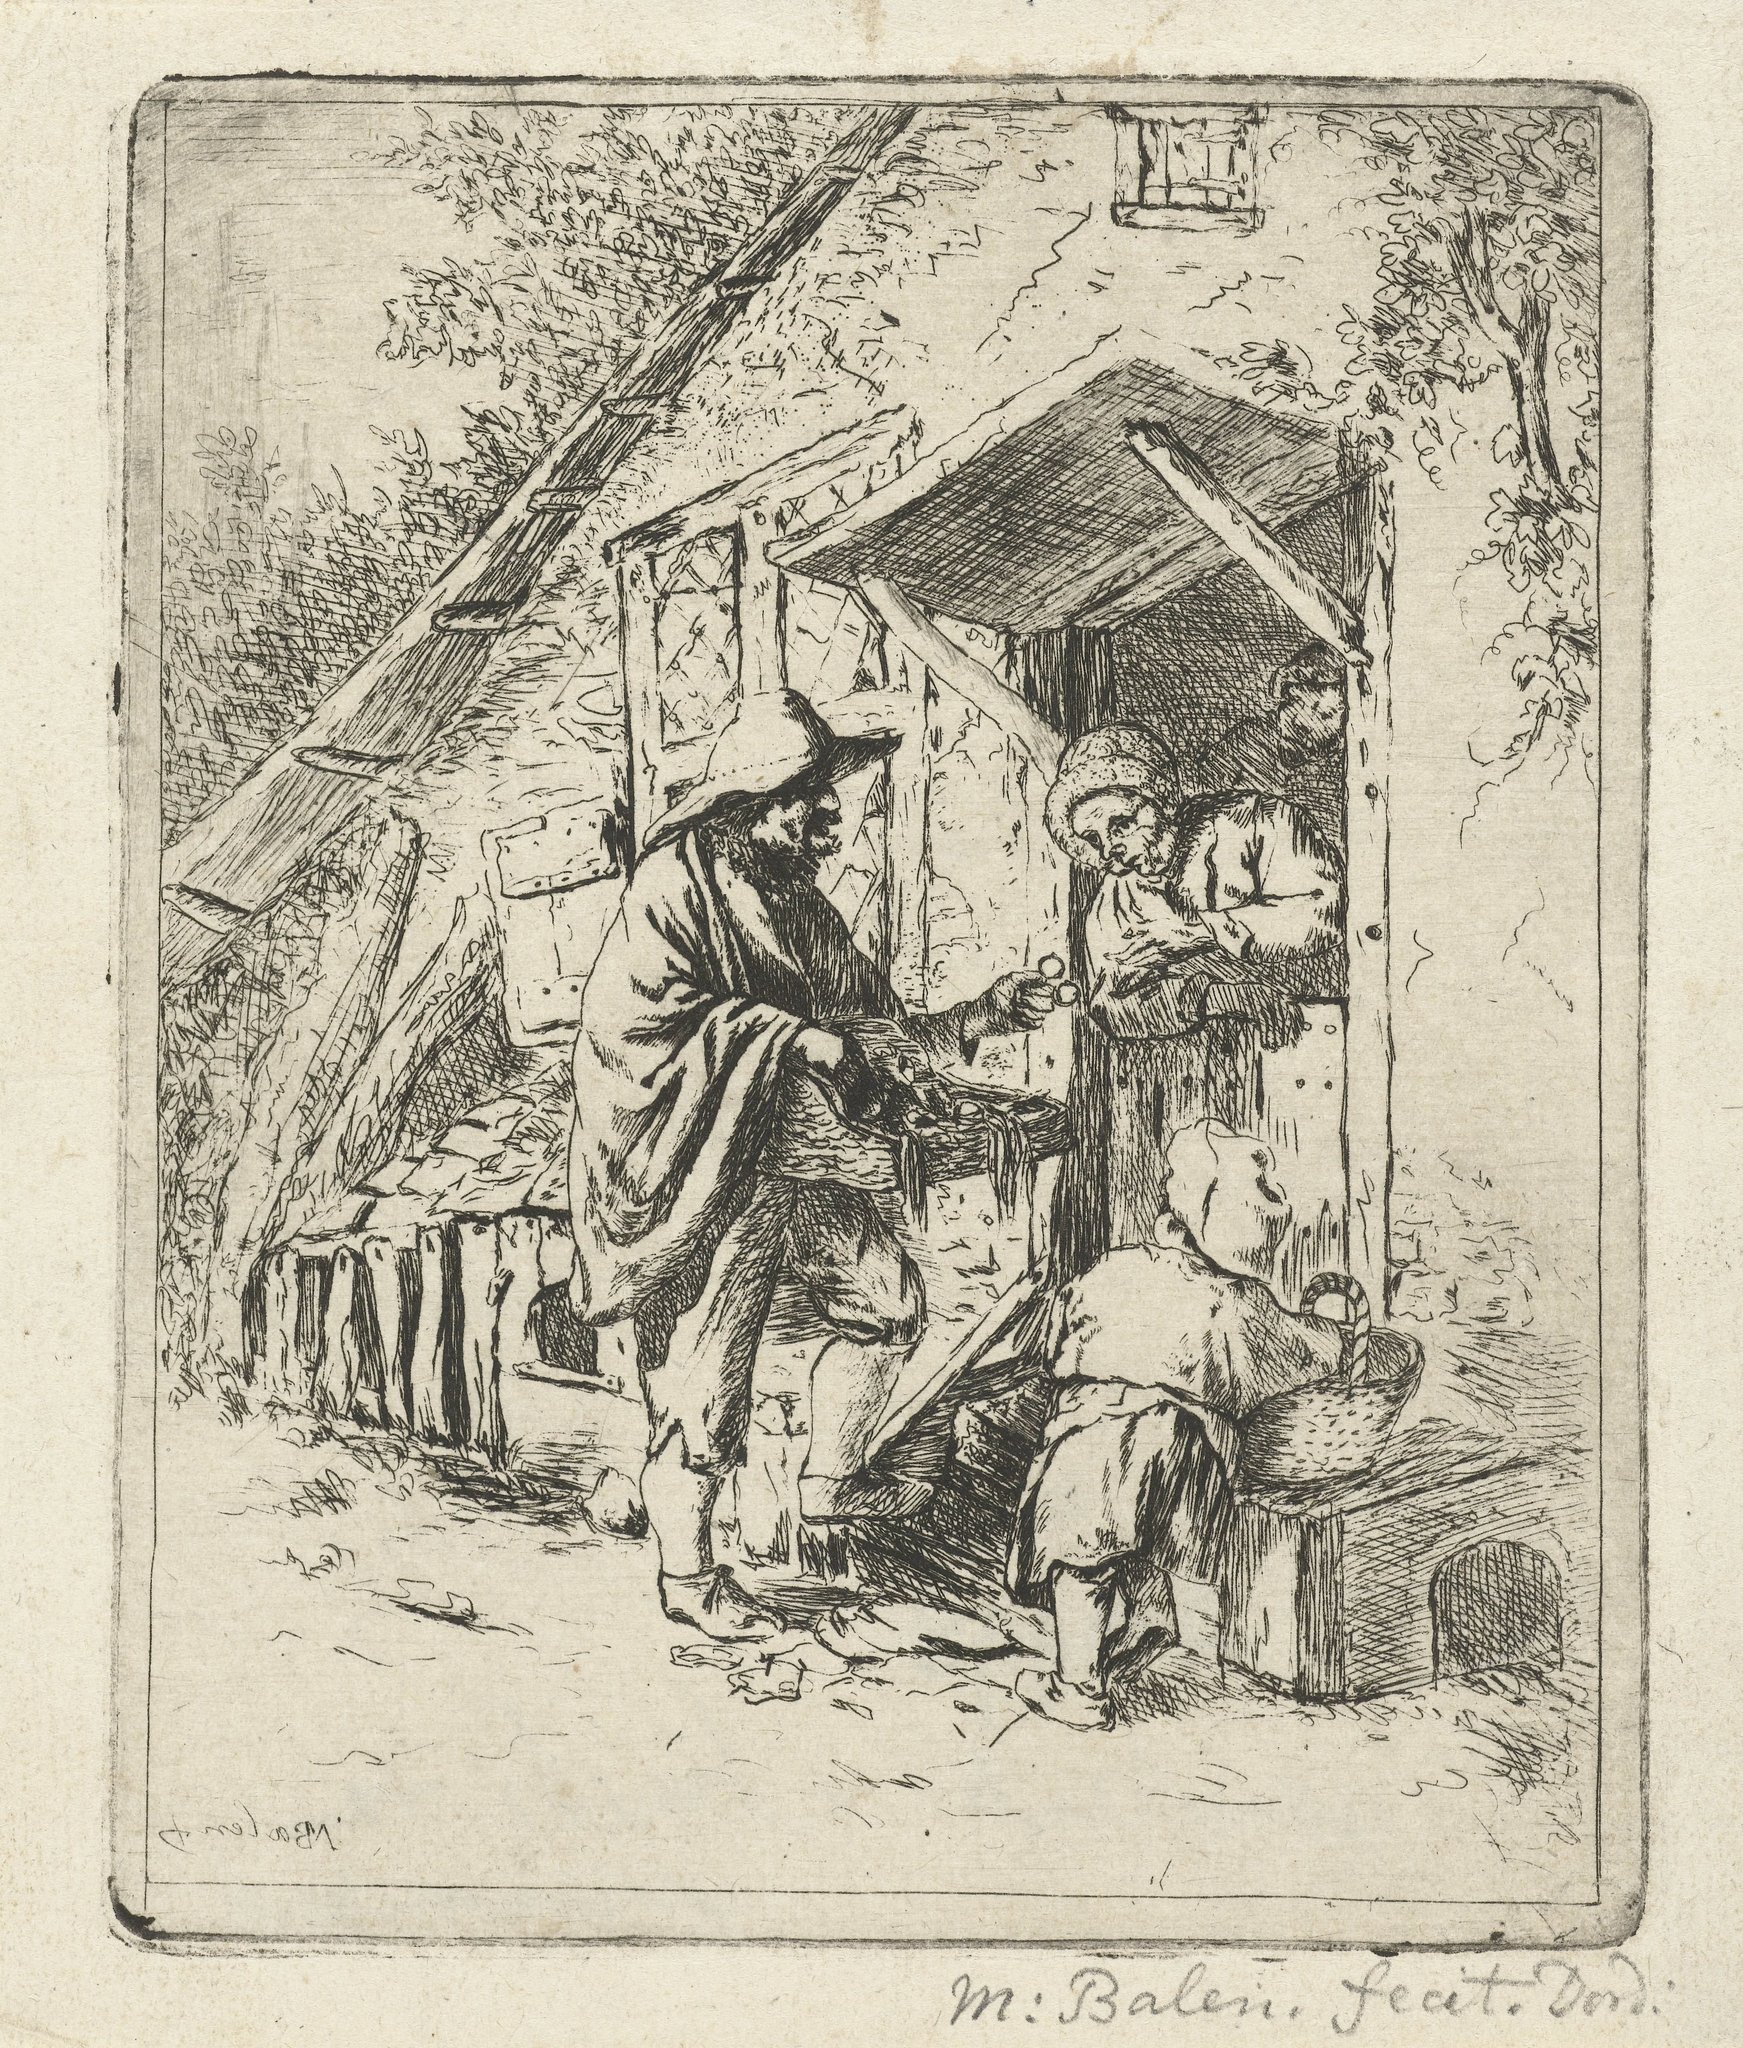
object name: print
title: Brillenverkoper en een oude vrouw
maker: matthijs balen (1684-1766)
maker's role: draughtsman, painter, print maker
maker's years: 1684-1766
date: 1694-1766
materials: paper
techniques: etching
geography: netherlands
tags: eyeglasses, spectacles, old woman, wandering or travelling merchant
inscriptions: collector's mark: Lugt 2228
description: Een brillenverkoper met een mand vol brillen staat voor het huis van een oude vrouw. Zij leunt op de onderdeur terwijl ze een bril krijgt aangereikt. Een kind met een mand kijkt toe. Waarschijnlijk kan de verkoper als een bedrieger geïnterpreteerd worden.